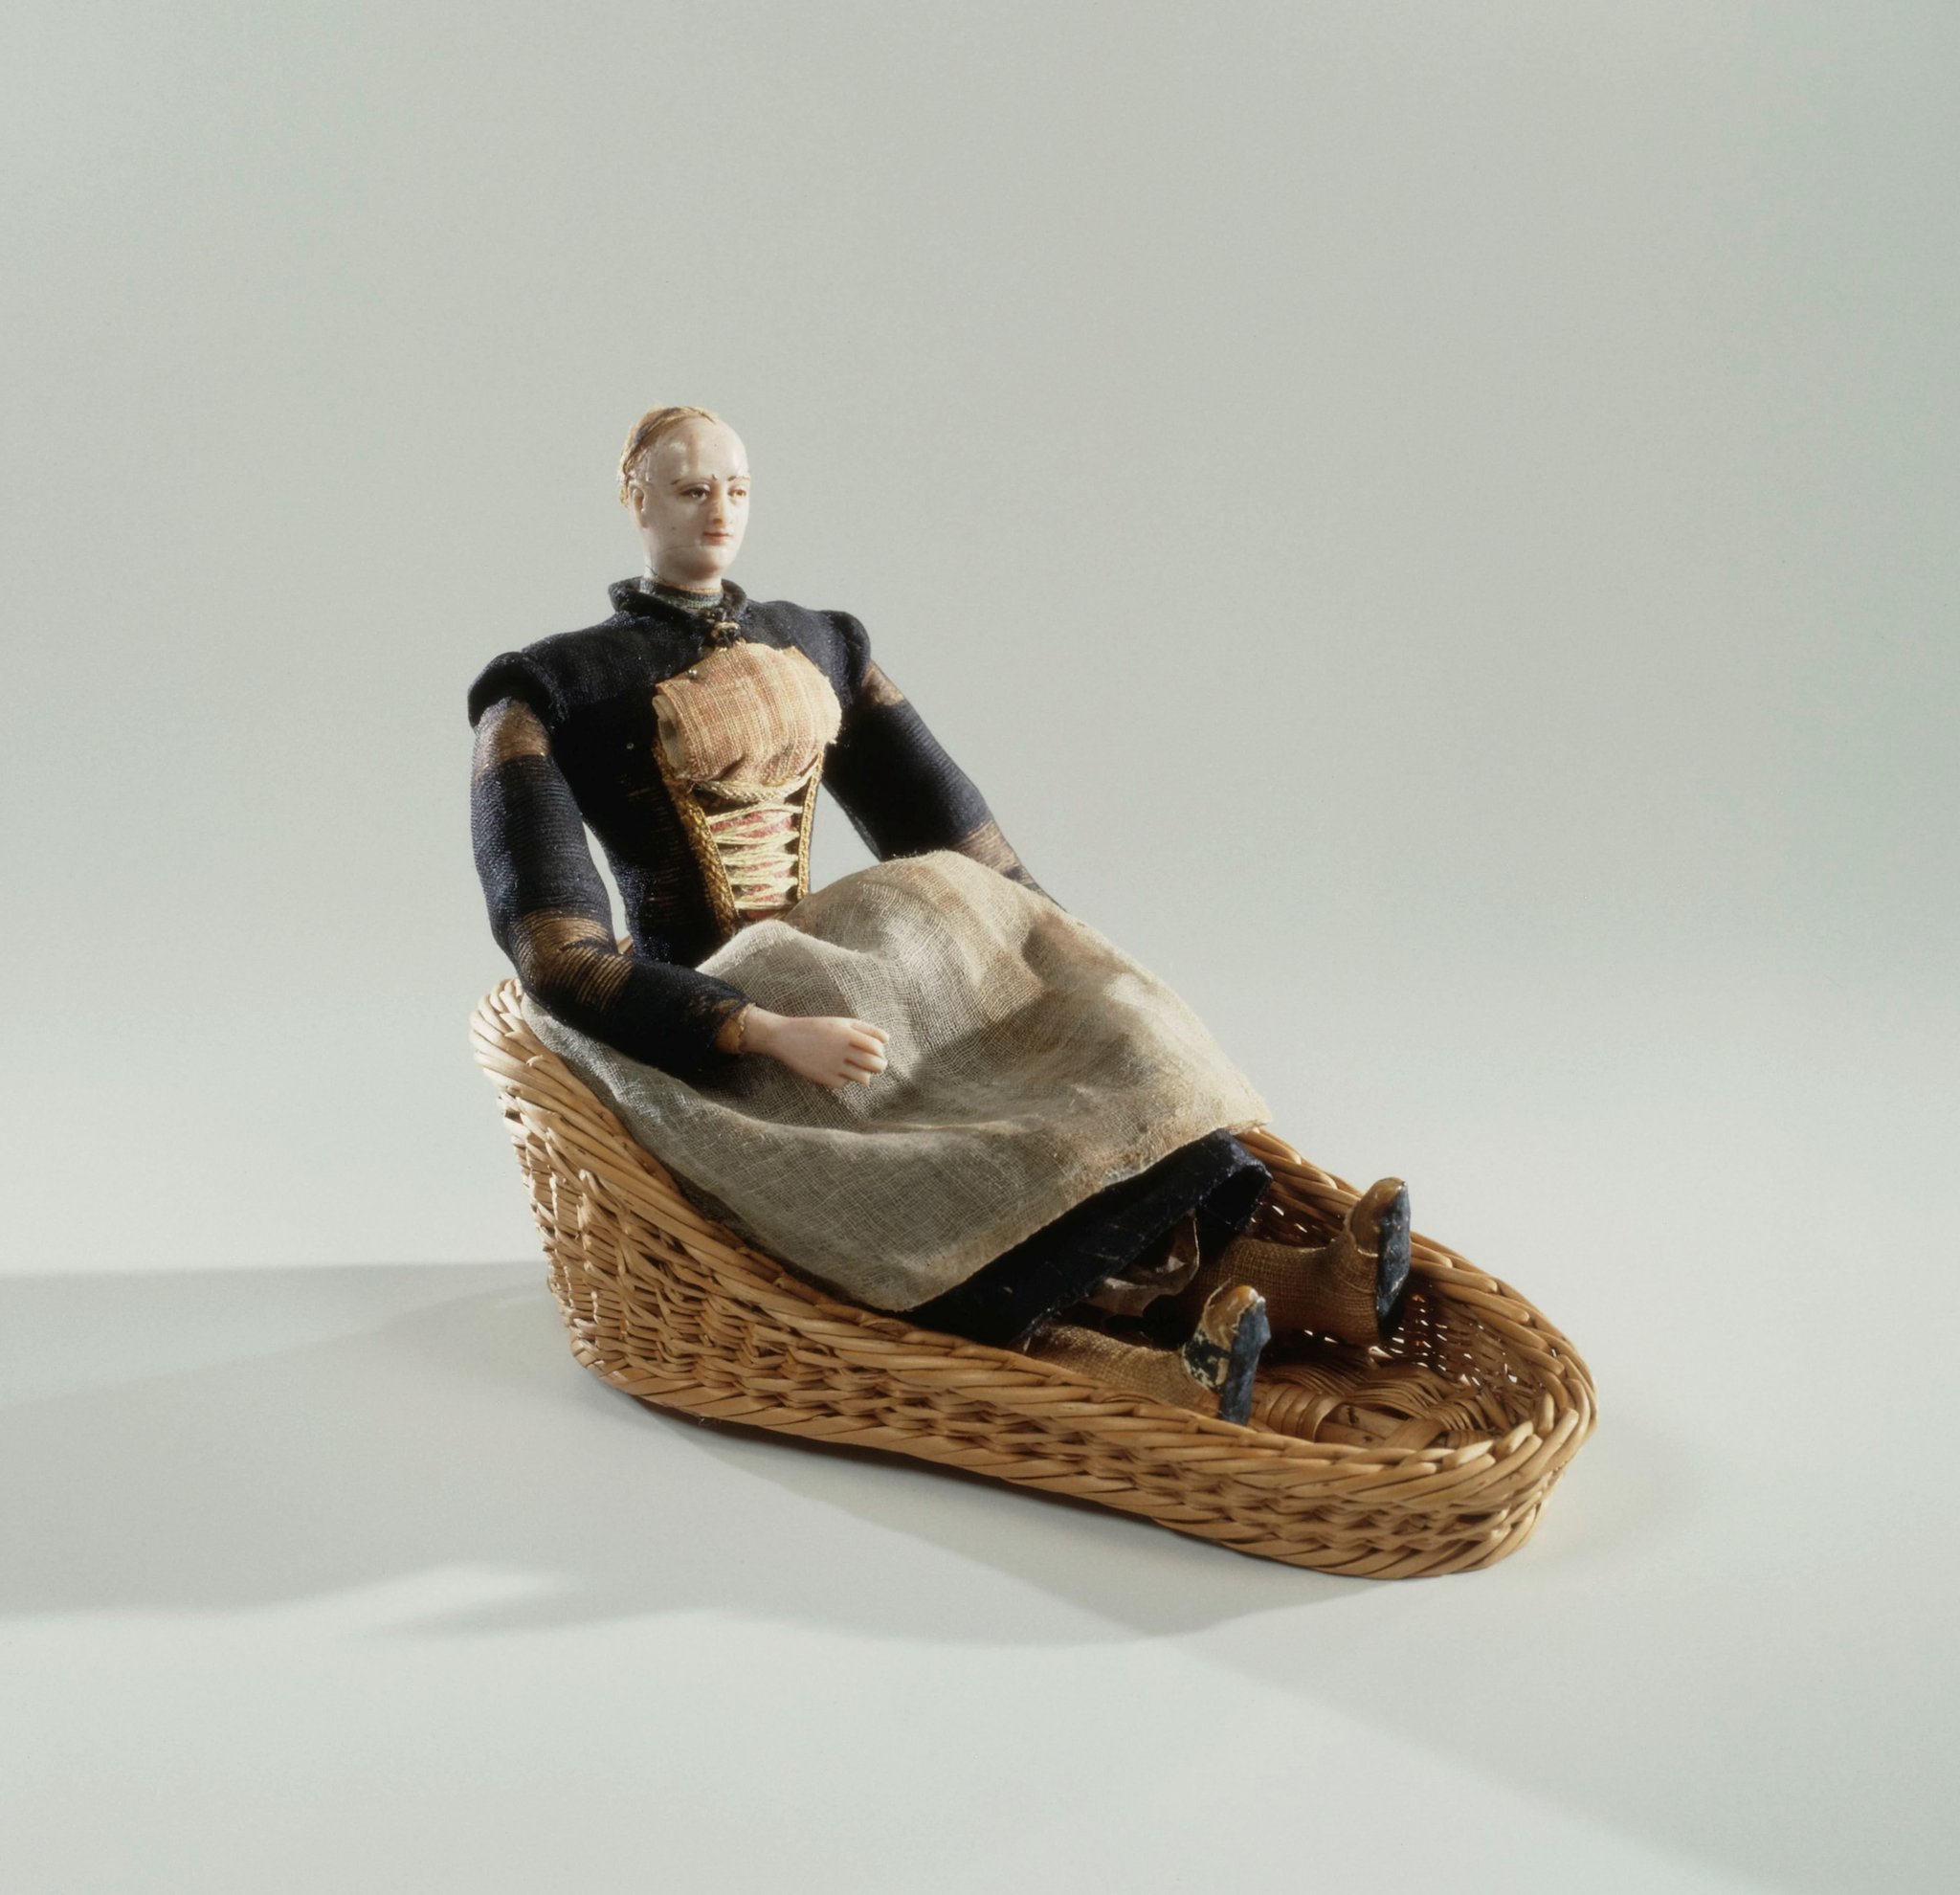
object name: doll's clothing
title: Pop, een ingebakende baby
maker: Anonymous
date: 1600-1699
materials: textile